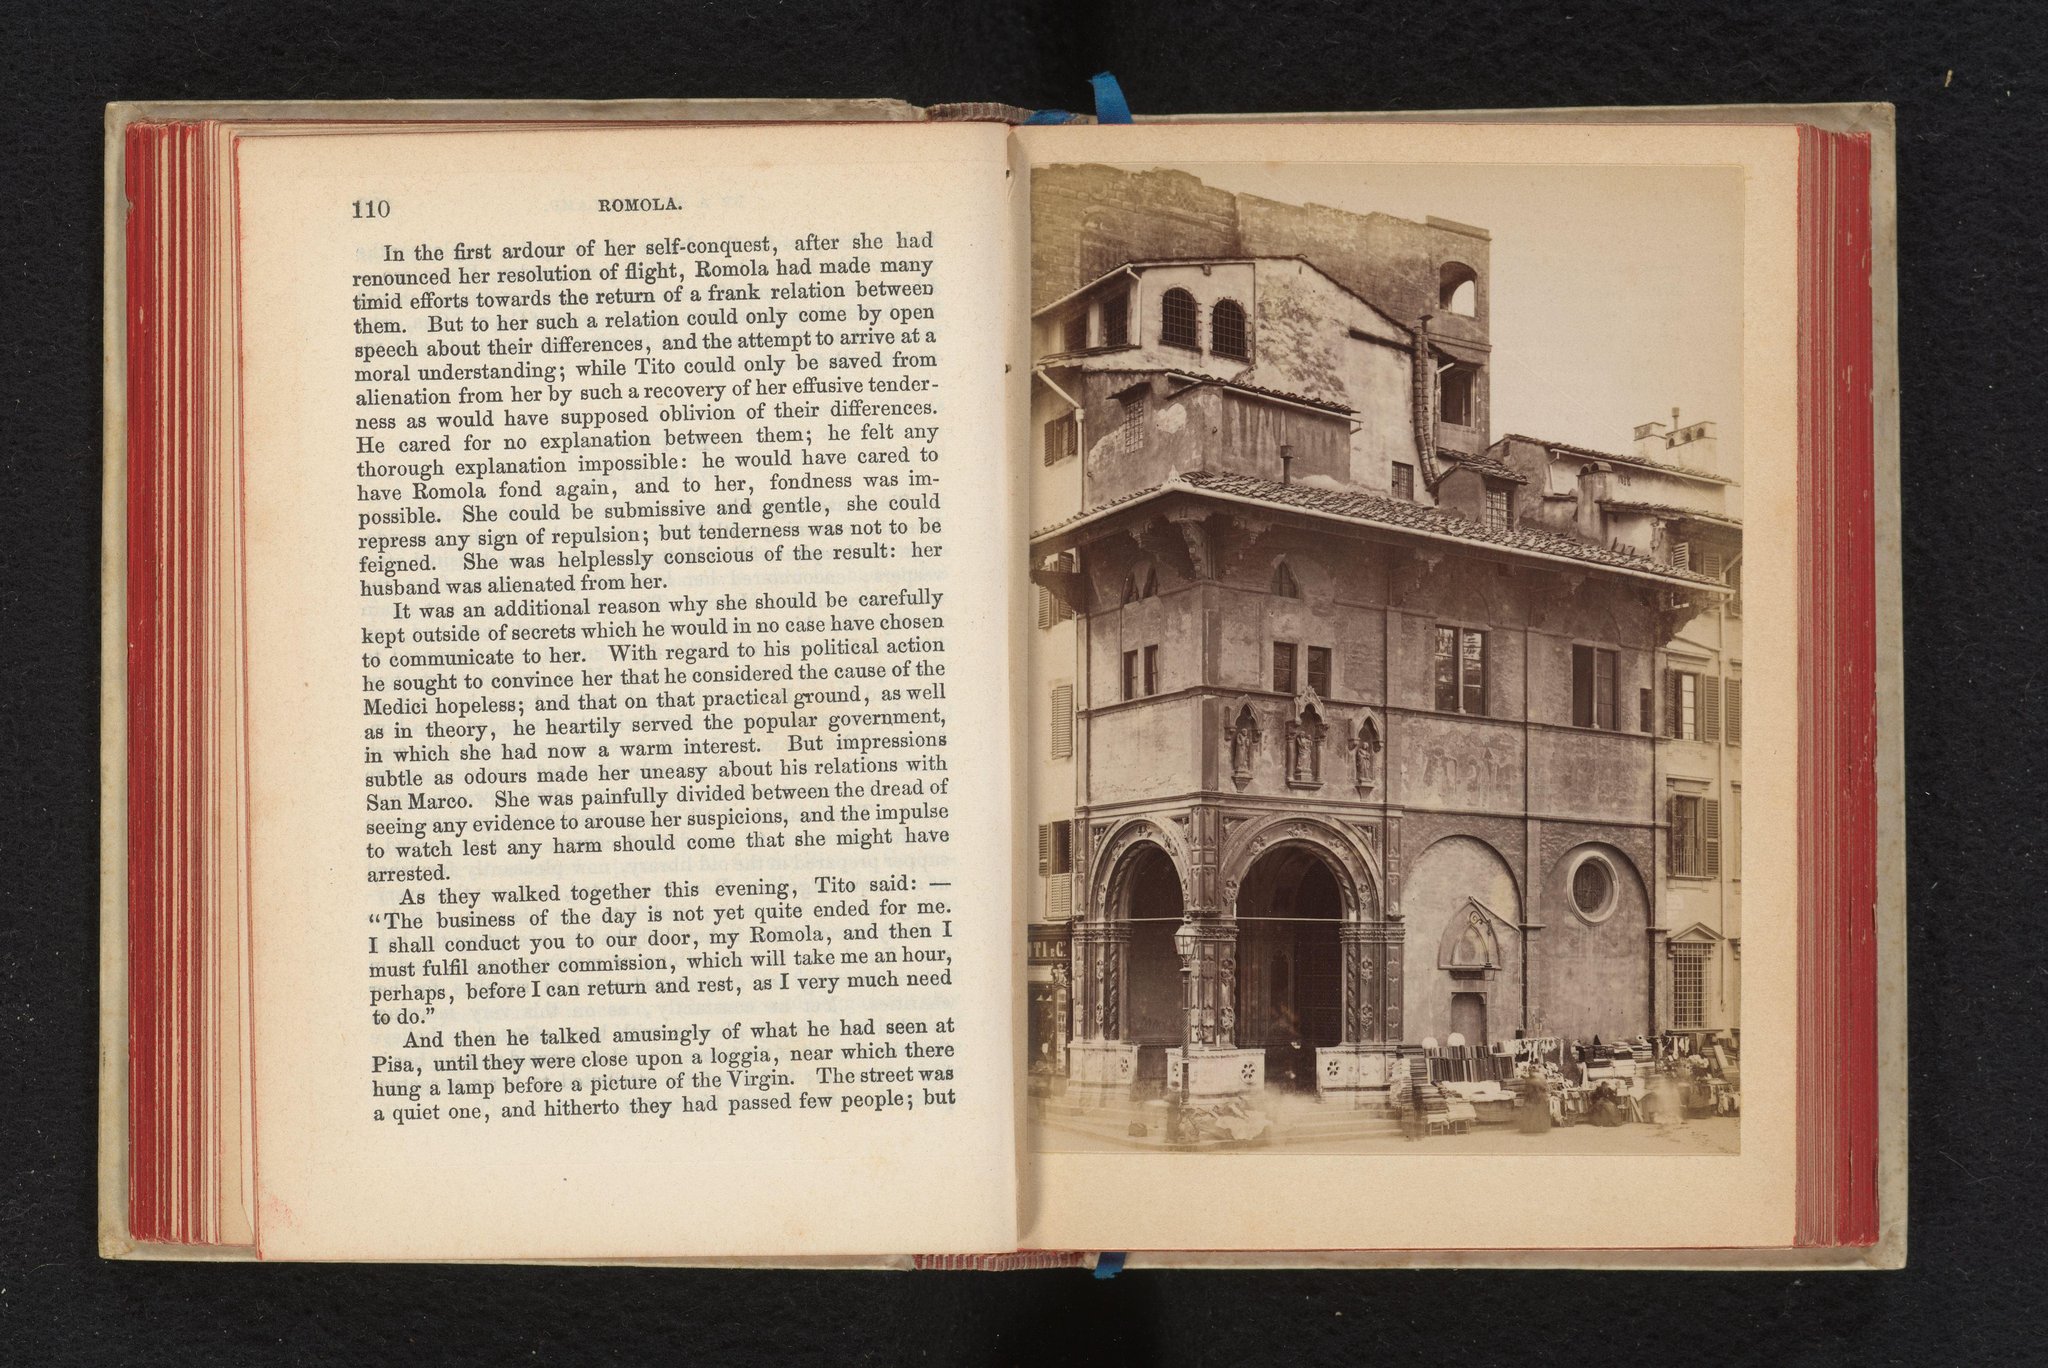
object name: page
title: Loggia del Bigallo te Florence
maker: giacomo brogi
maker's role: fotograaf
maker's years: 1822-1881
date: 1858-1863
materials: paper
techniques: albumen print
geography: florence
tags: urban housing, loggia, verandah, porch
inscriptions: name: ‘Brogi’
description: Foto op ongenummerde pagina tegenover pagina 110.